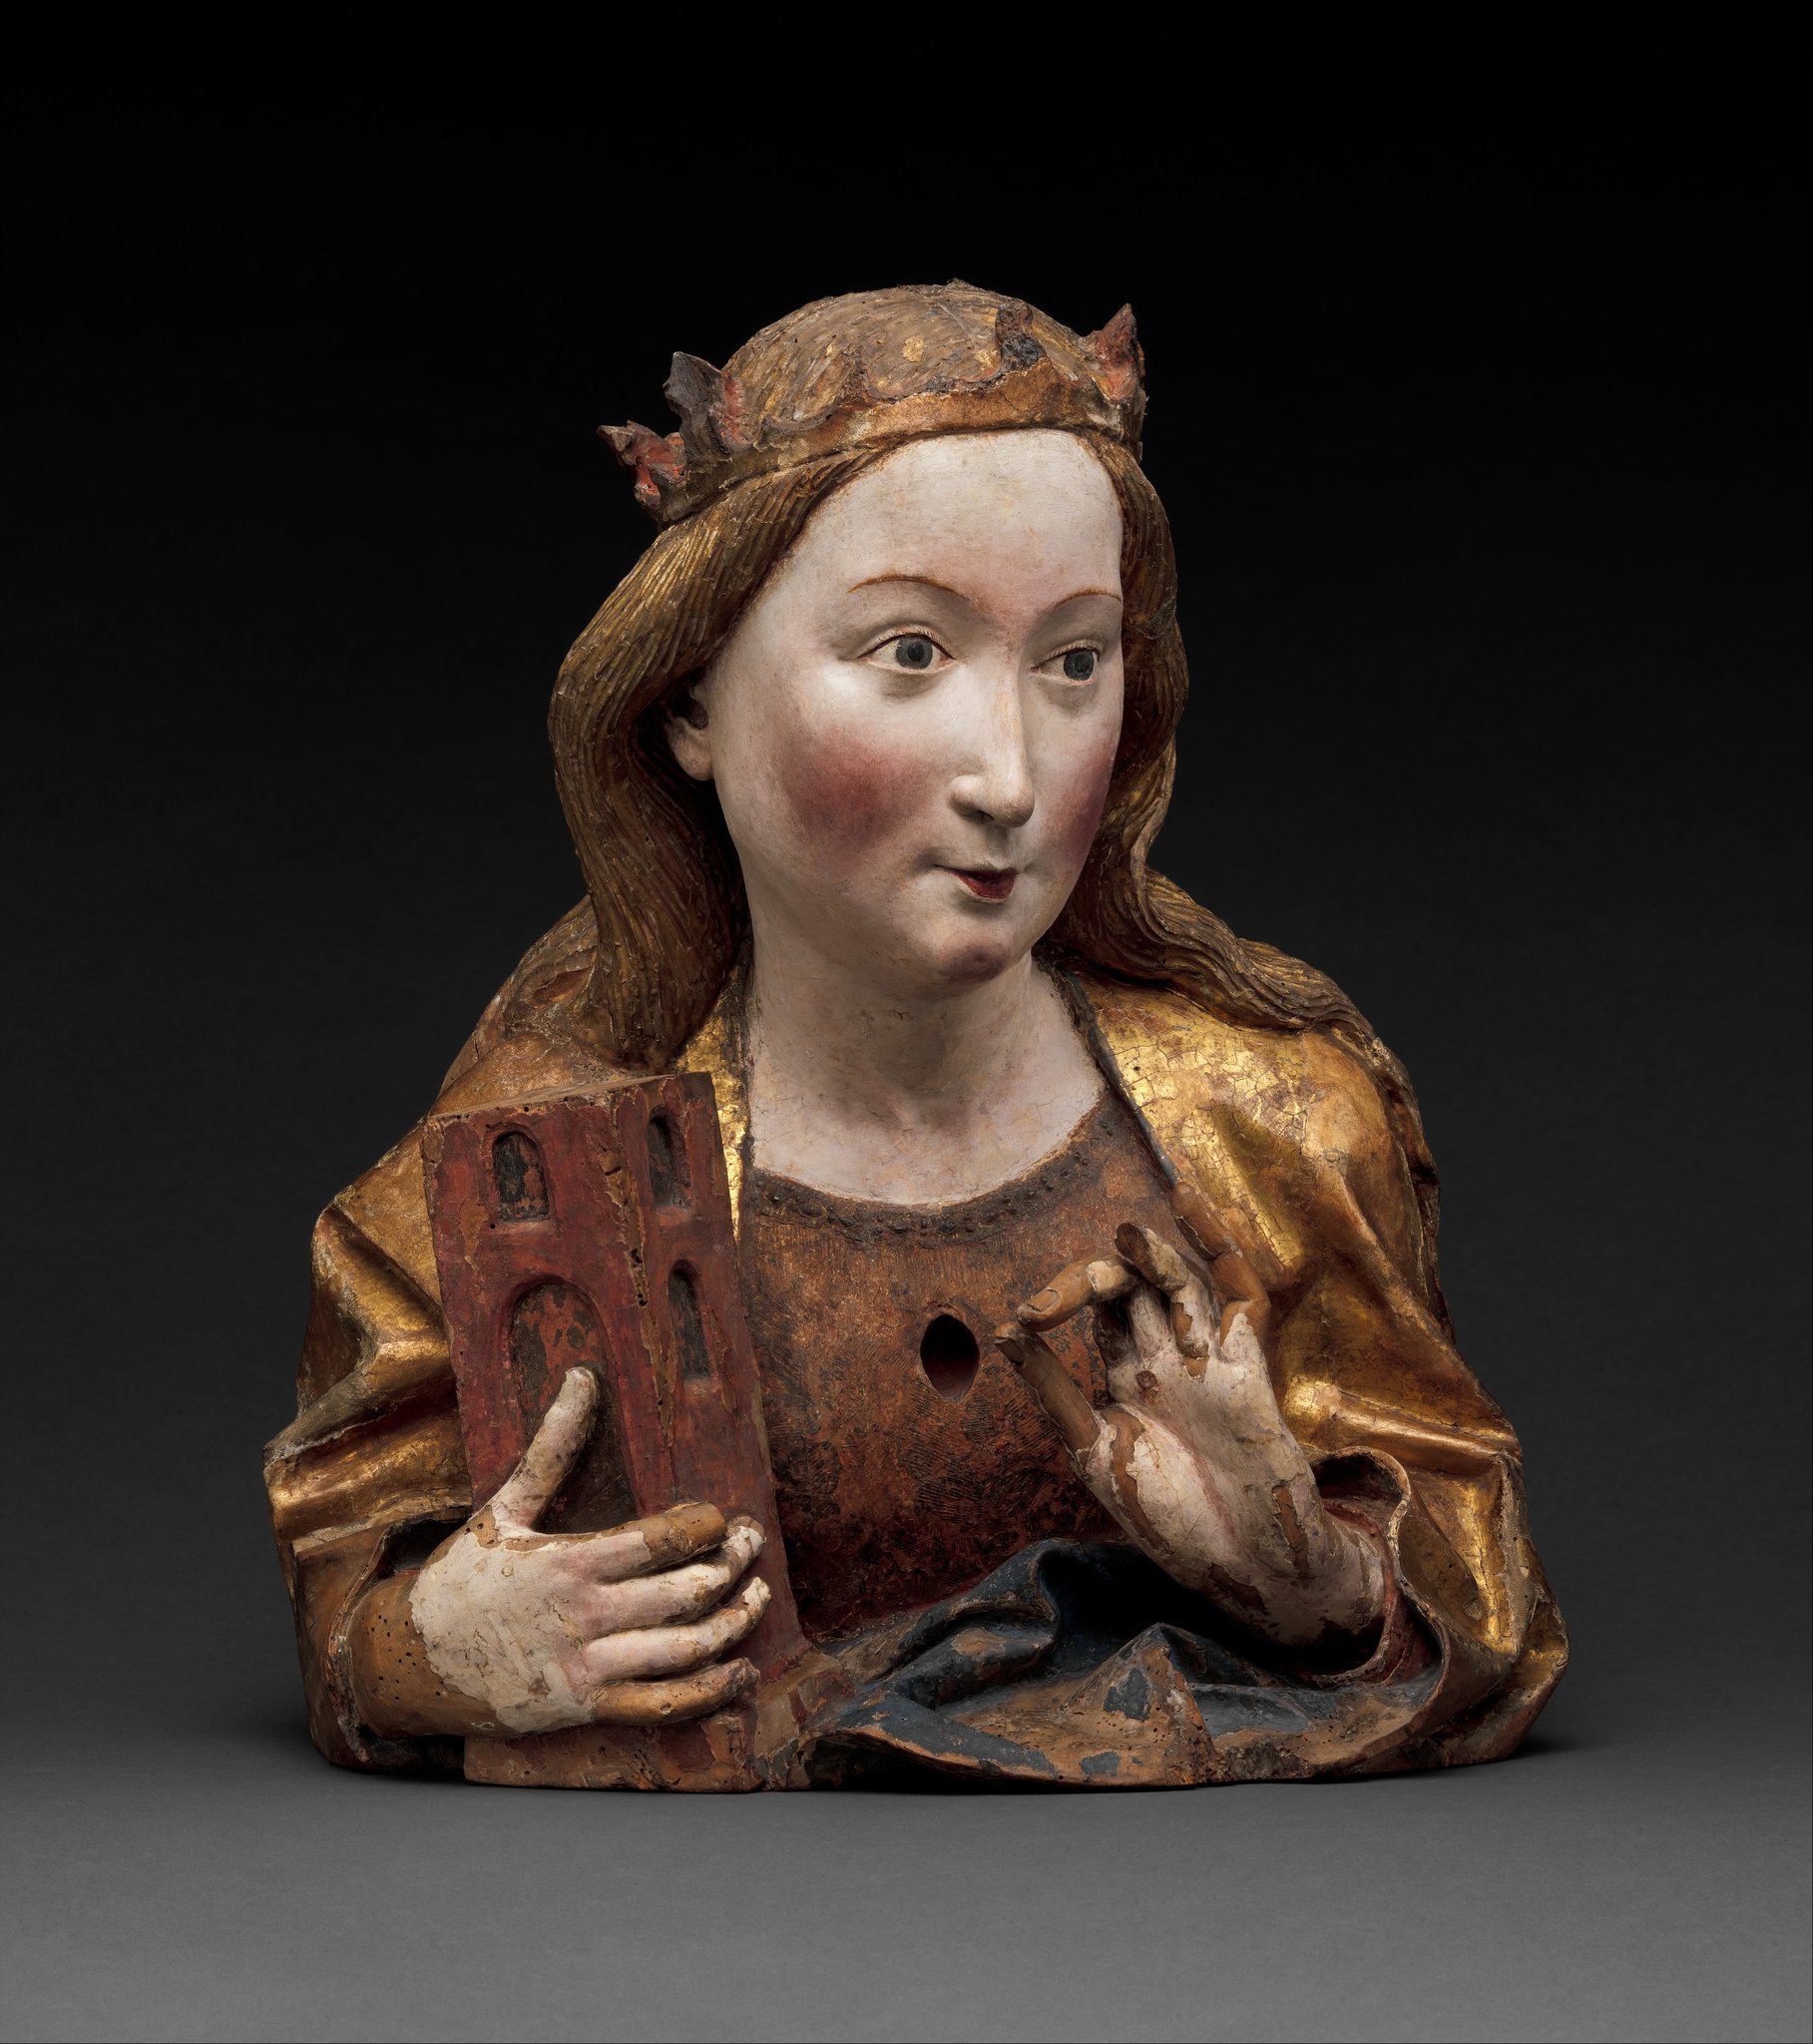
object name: reliquary bust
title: Reliquary Bust of Saint Barbara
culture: german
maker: niclaus gerhaert von leyden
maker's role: artist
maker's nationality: north netherlandish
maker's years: 1462-1473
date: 1465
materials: paint, wood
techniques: gilding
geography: germany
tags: women